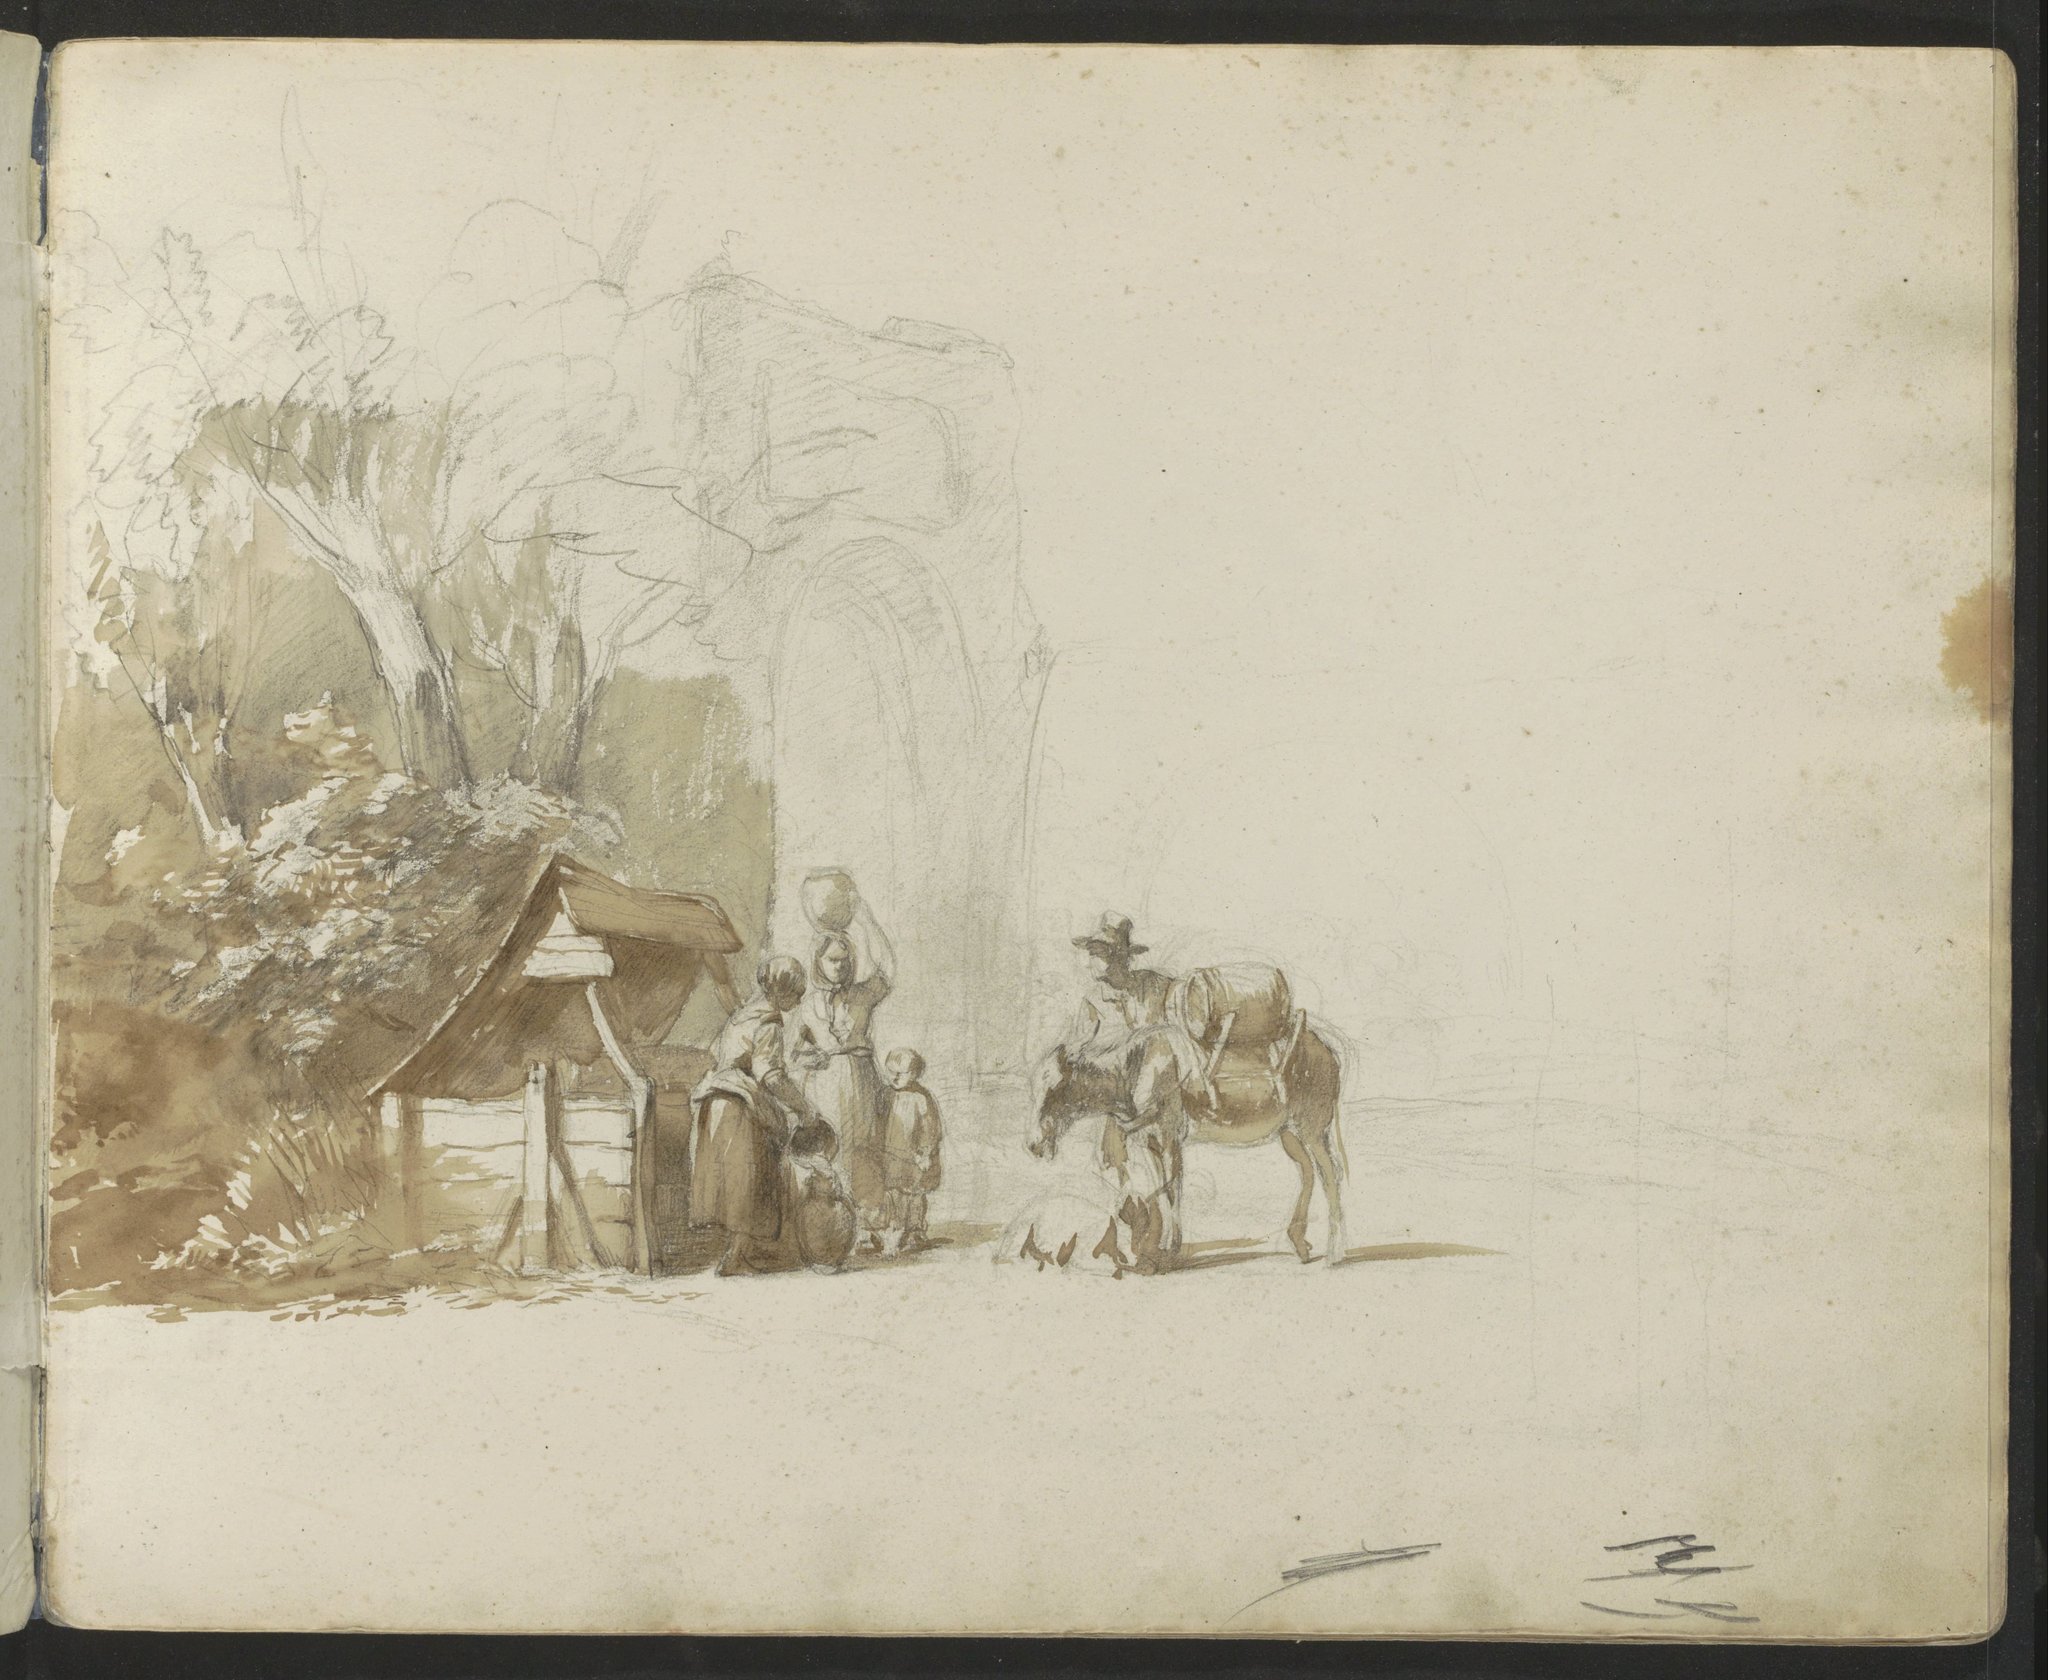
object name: sketchbook leaf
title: Figuren bij een waterput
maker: Anonymous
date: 1800-1899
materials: chalk, ink, paper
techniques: brush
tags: well, gate, entrance, landscapes (+ landscape with figures, staffage)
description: Landschap met een poort, bomen en waterput. Bij de waterput staan drie meisjes met vazen en een man met een ezel. Blad 1 recto uit een schetsboek met 13 bladen.